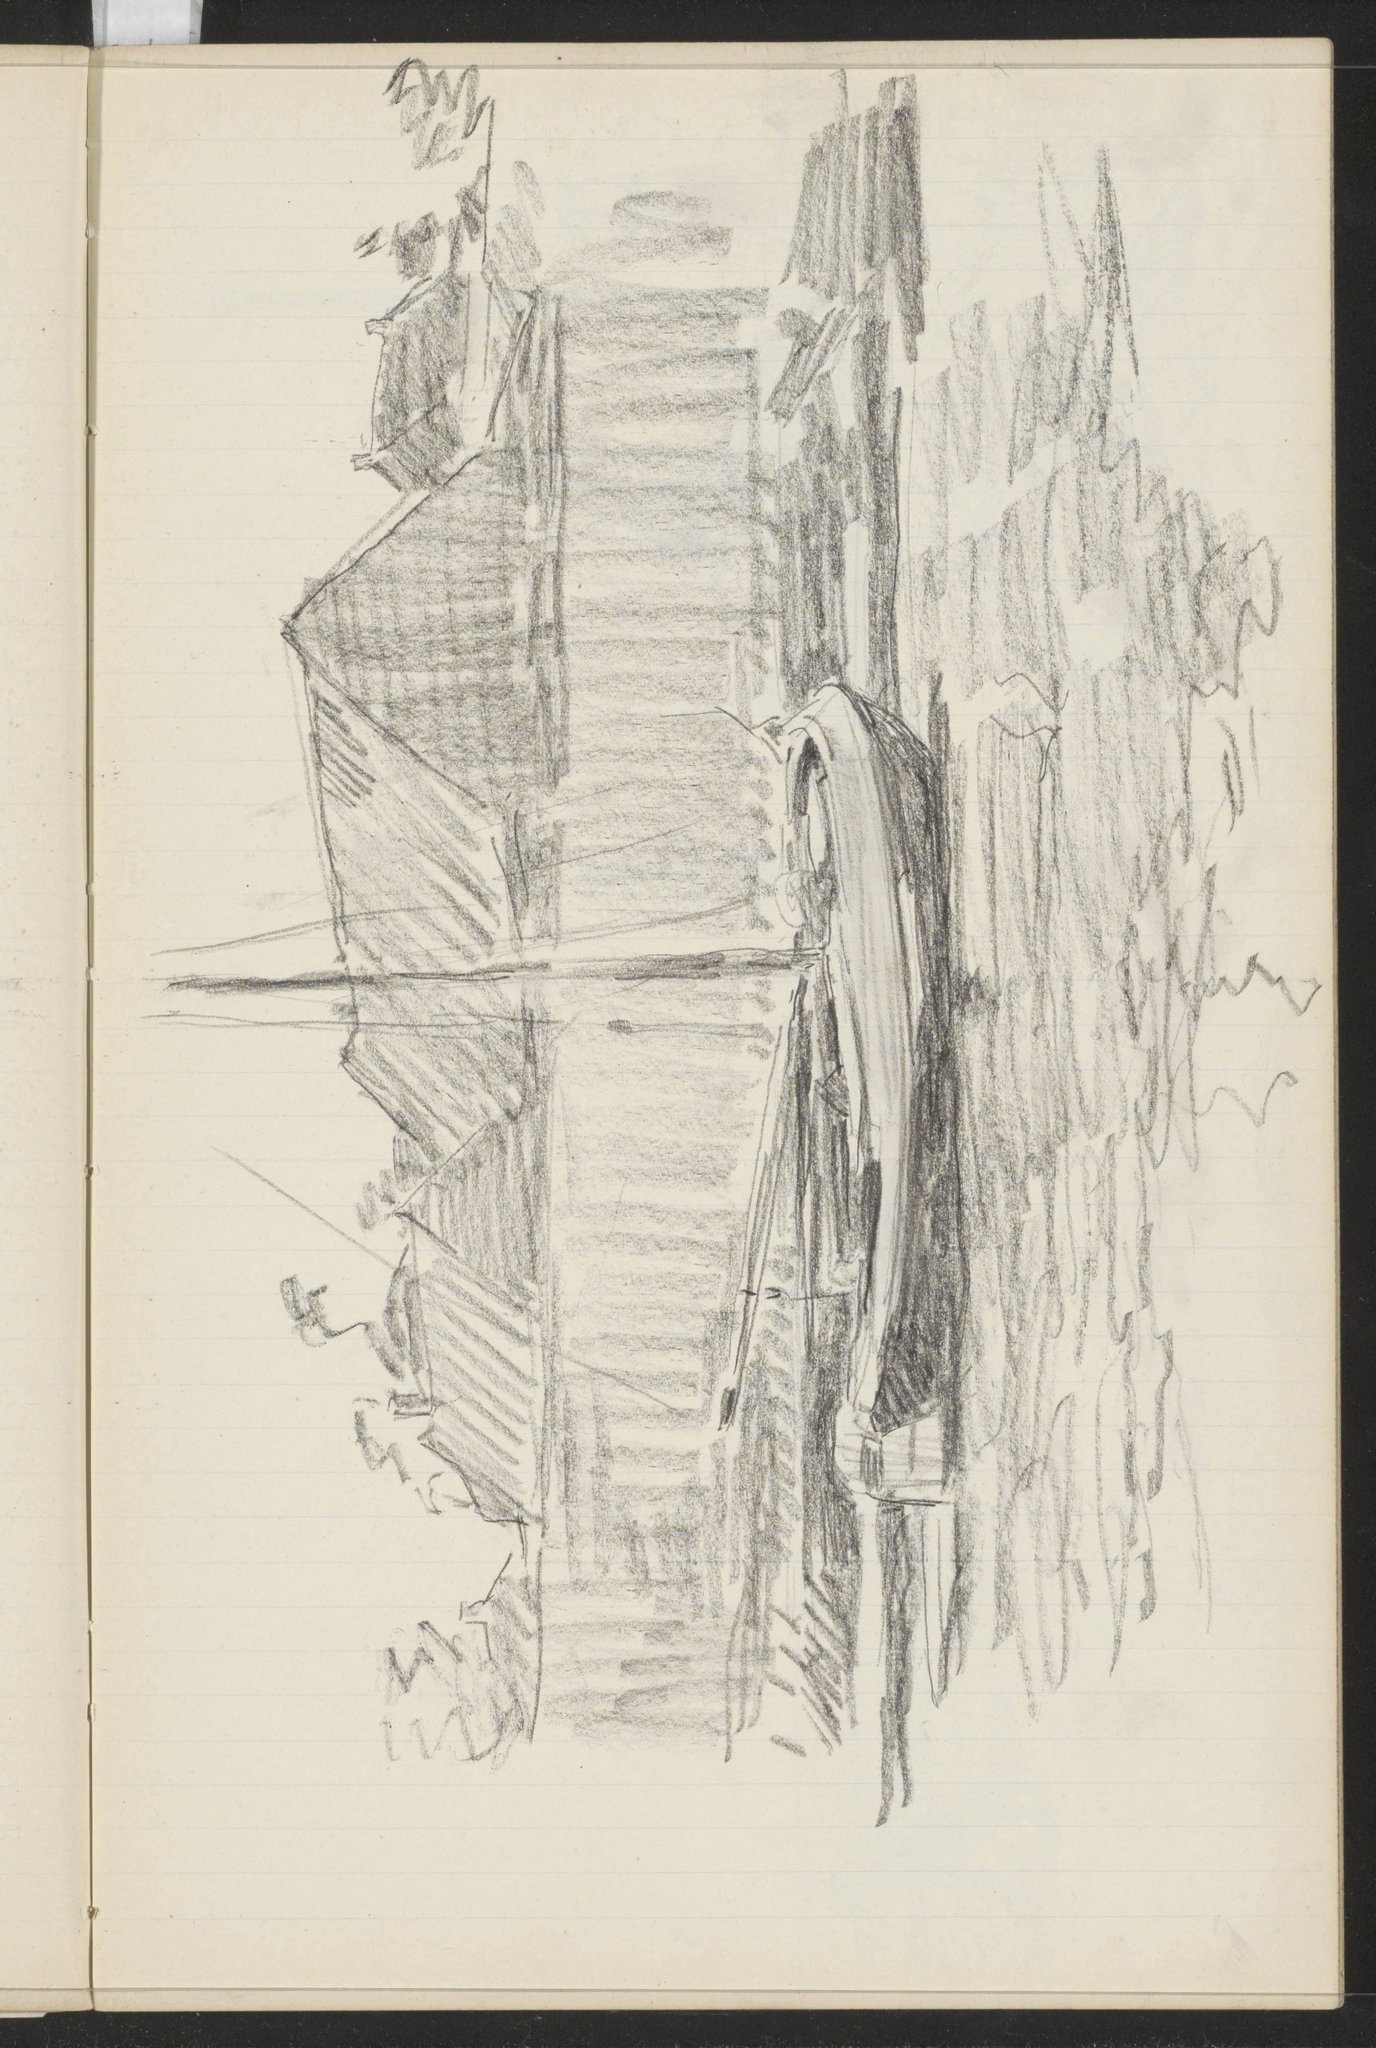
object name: sketchbook leaf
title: Zeilschip op een rivier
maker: willem bastiaan tholen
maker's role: draughtsman, painter, print maker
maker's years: 1860-1931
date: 1900-1931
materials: chalk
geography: enkhuizen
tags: sailing-ship, sailing-boat, river, housing, enkhuizen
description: Op de achtergrond enkele huizen. Blad 15 recto uit een schetsboek met 55 bladen.